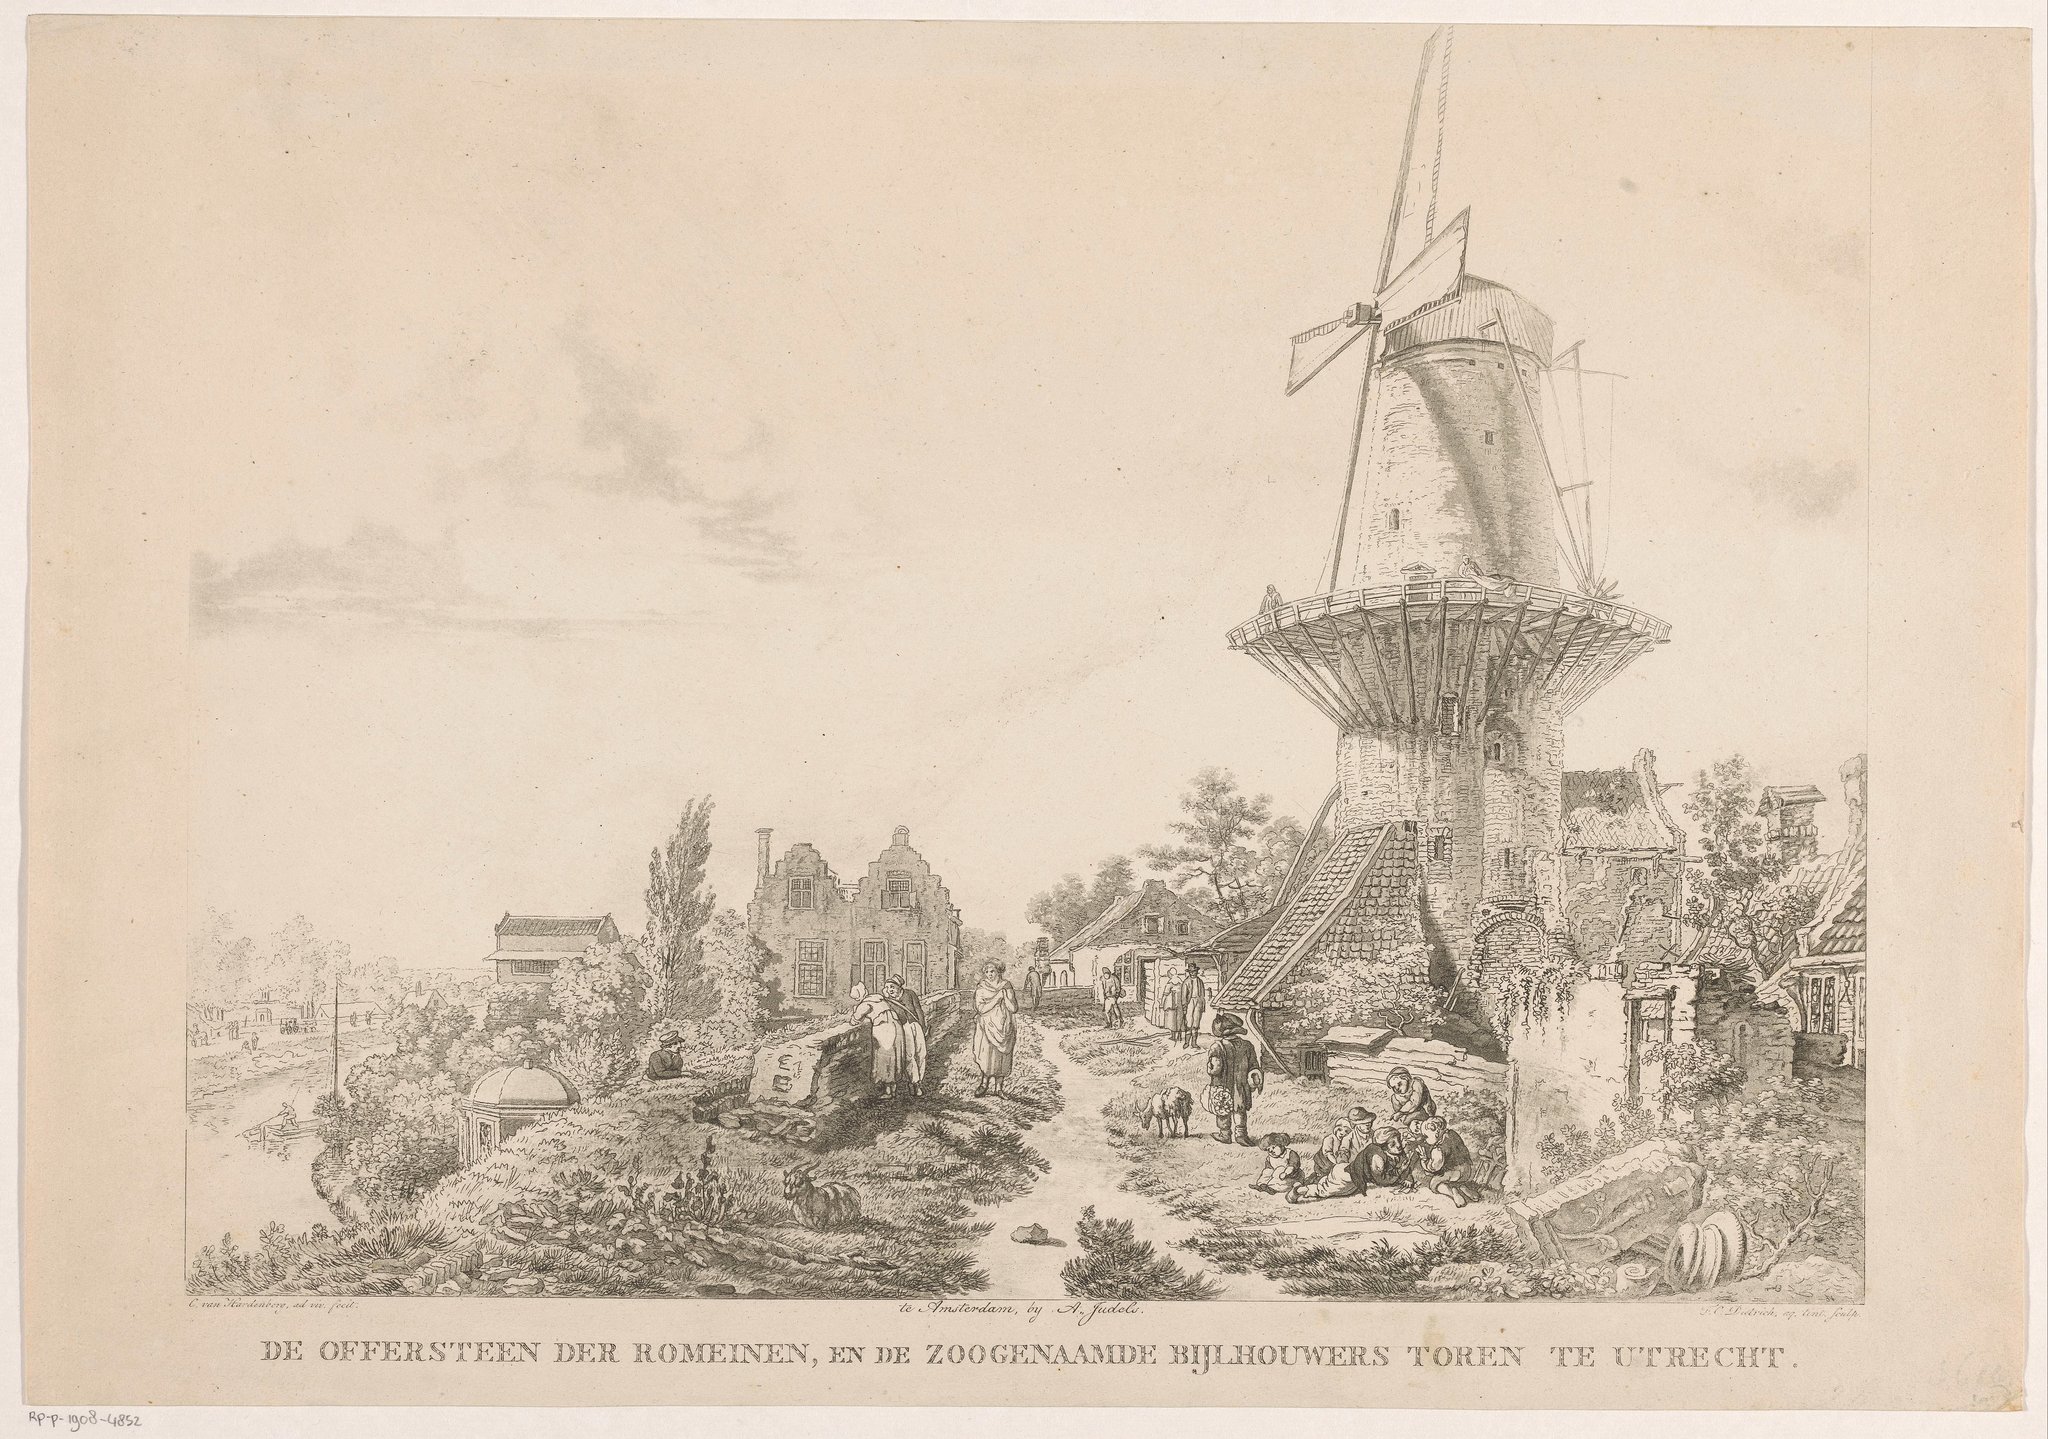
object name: print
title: Offersteen der Romeinen en de Bijlhouwerstoren in Utrecht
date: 1817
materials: paper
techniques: aquatint, etching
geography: netherlands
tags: city-view, and landscape with man-made constructions, windmill in landscape, public road in village, goat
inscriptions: collector's mark: Lugt 2228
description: Prent in eerder staat ook gebruikt voor: Johannes Weppelman, Verzameling van bouw- en beeldhouwkunst, en vele verdere zeldzaamheden ..., Utrecht (W.F. Stamrood) 1817. Los tekstblad met beschrijving aanwezig bij RMA.